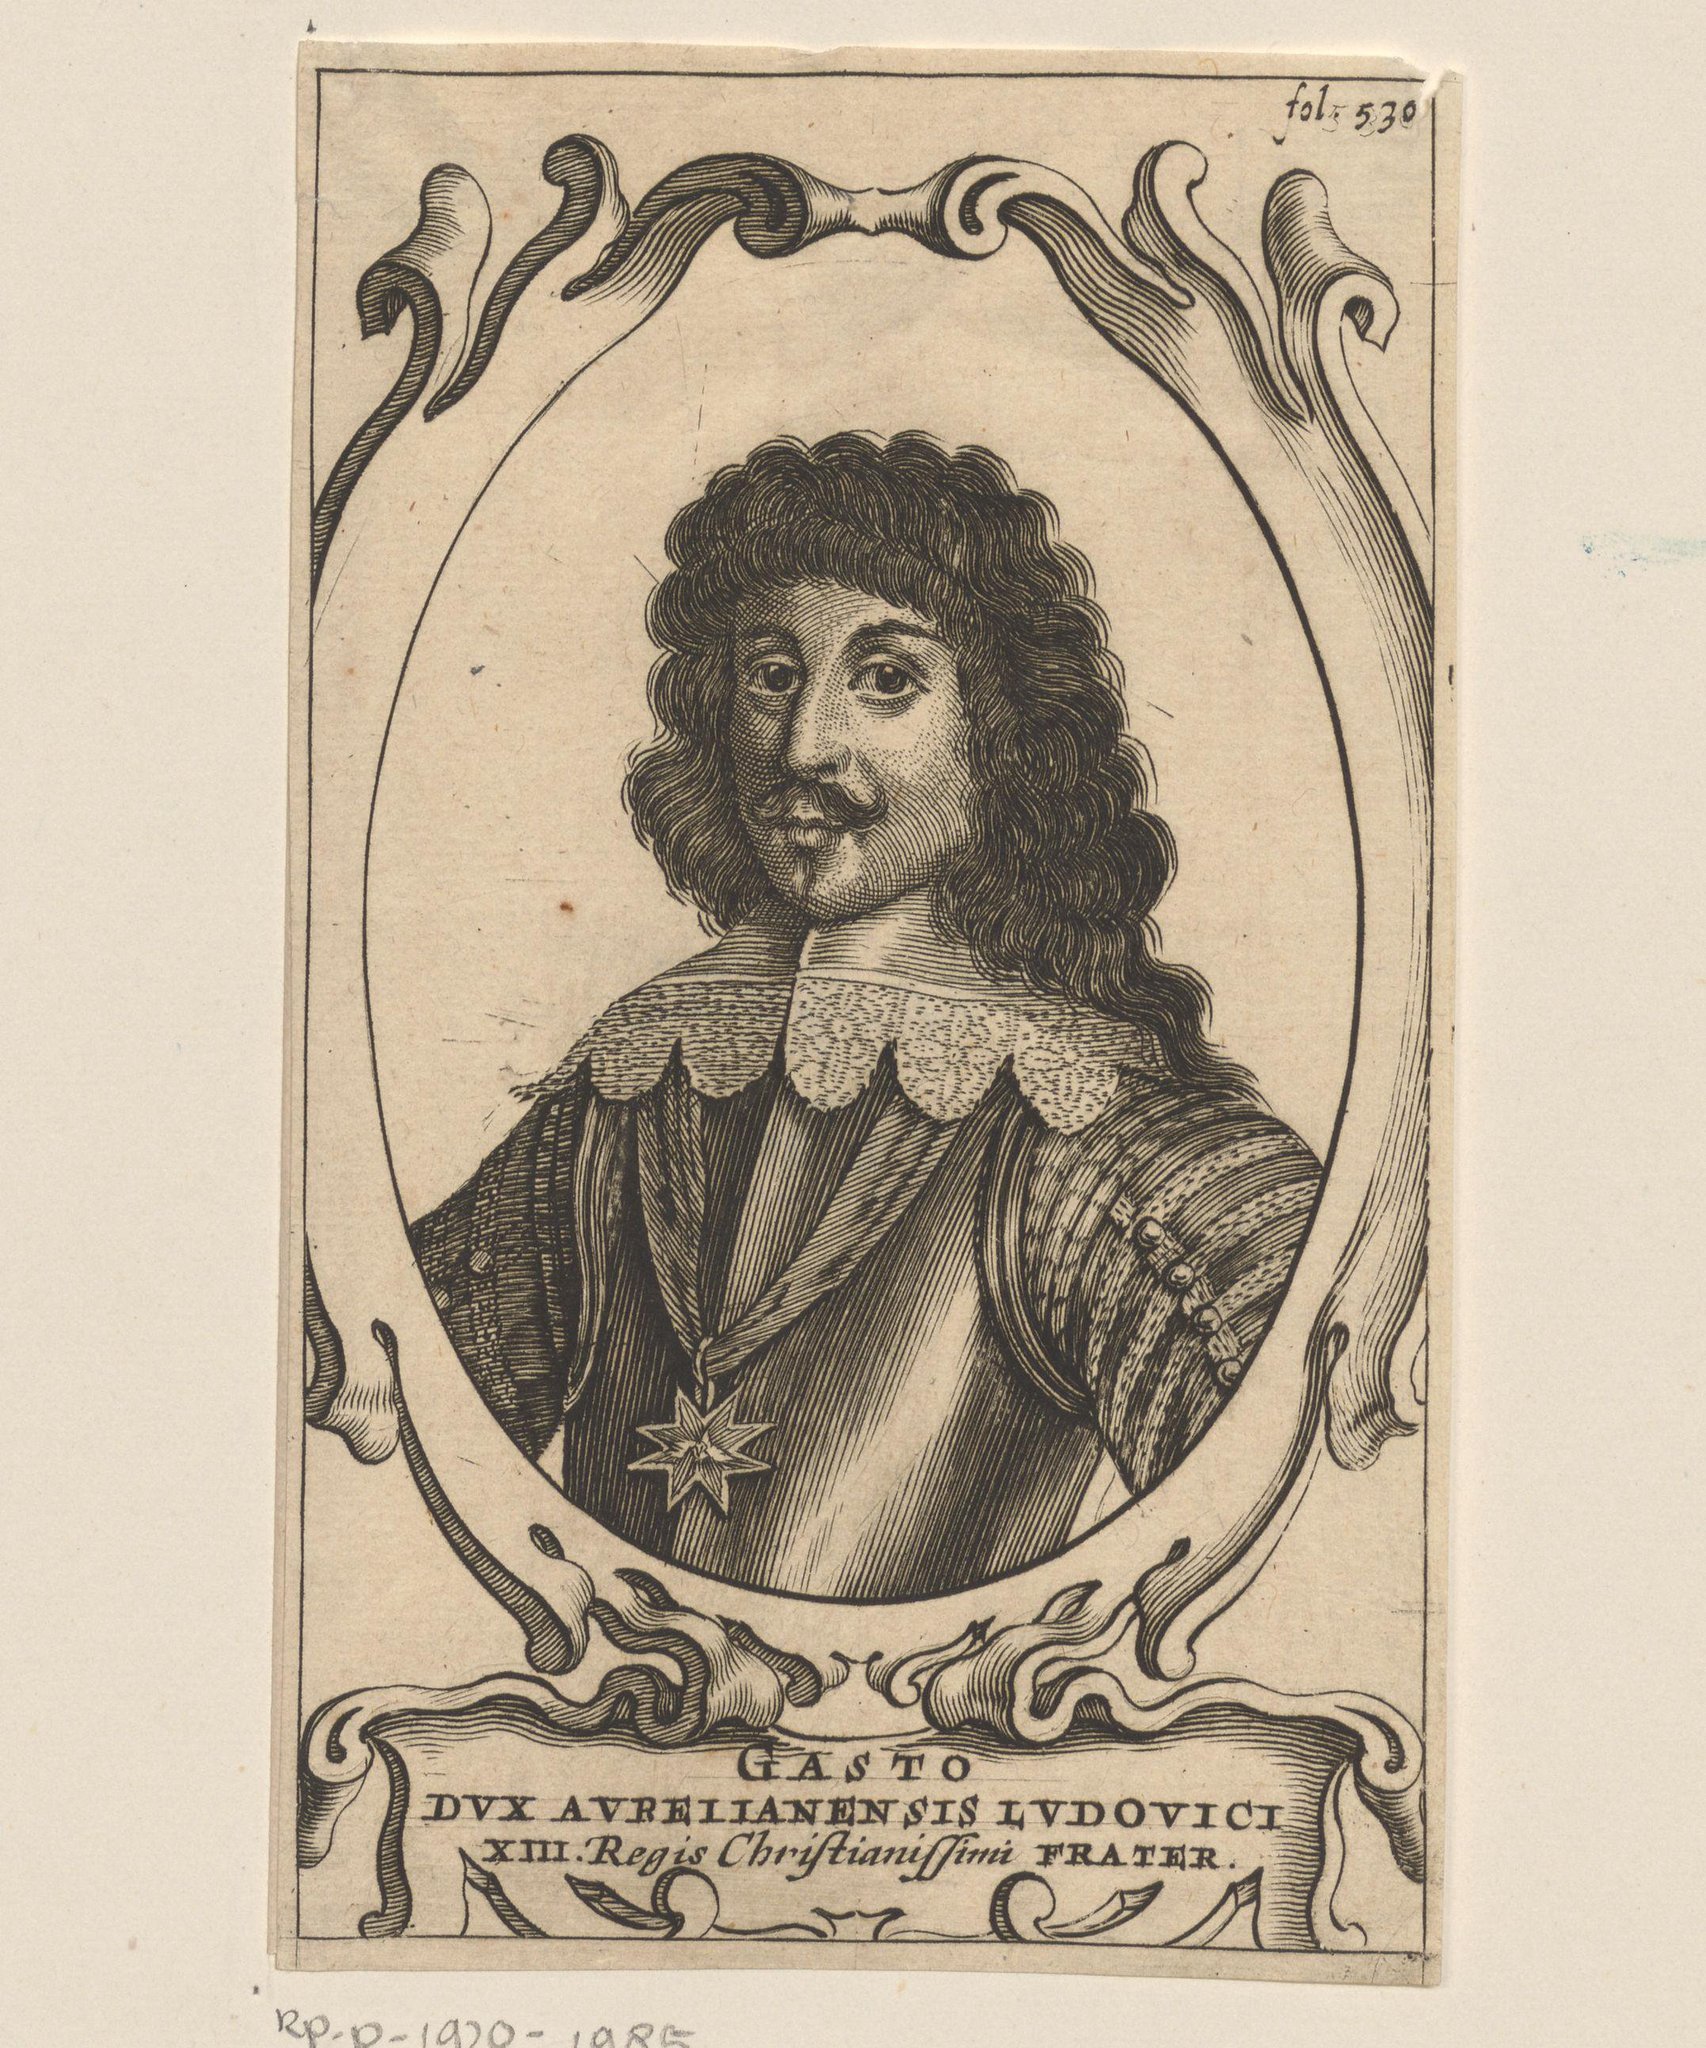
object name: print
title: Portret van Gaston Jean-Baptiste Orléans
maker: Anonymous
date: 1654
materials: paper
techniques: engraving, etching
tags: gaston jean-baptiste hertog van orléans, historical persons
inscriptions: collector's mark: Lugt 2228